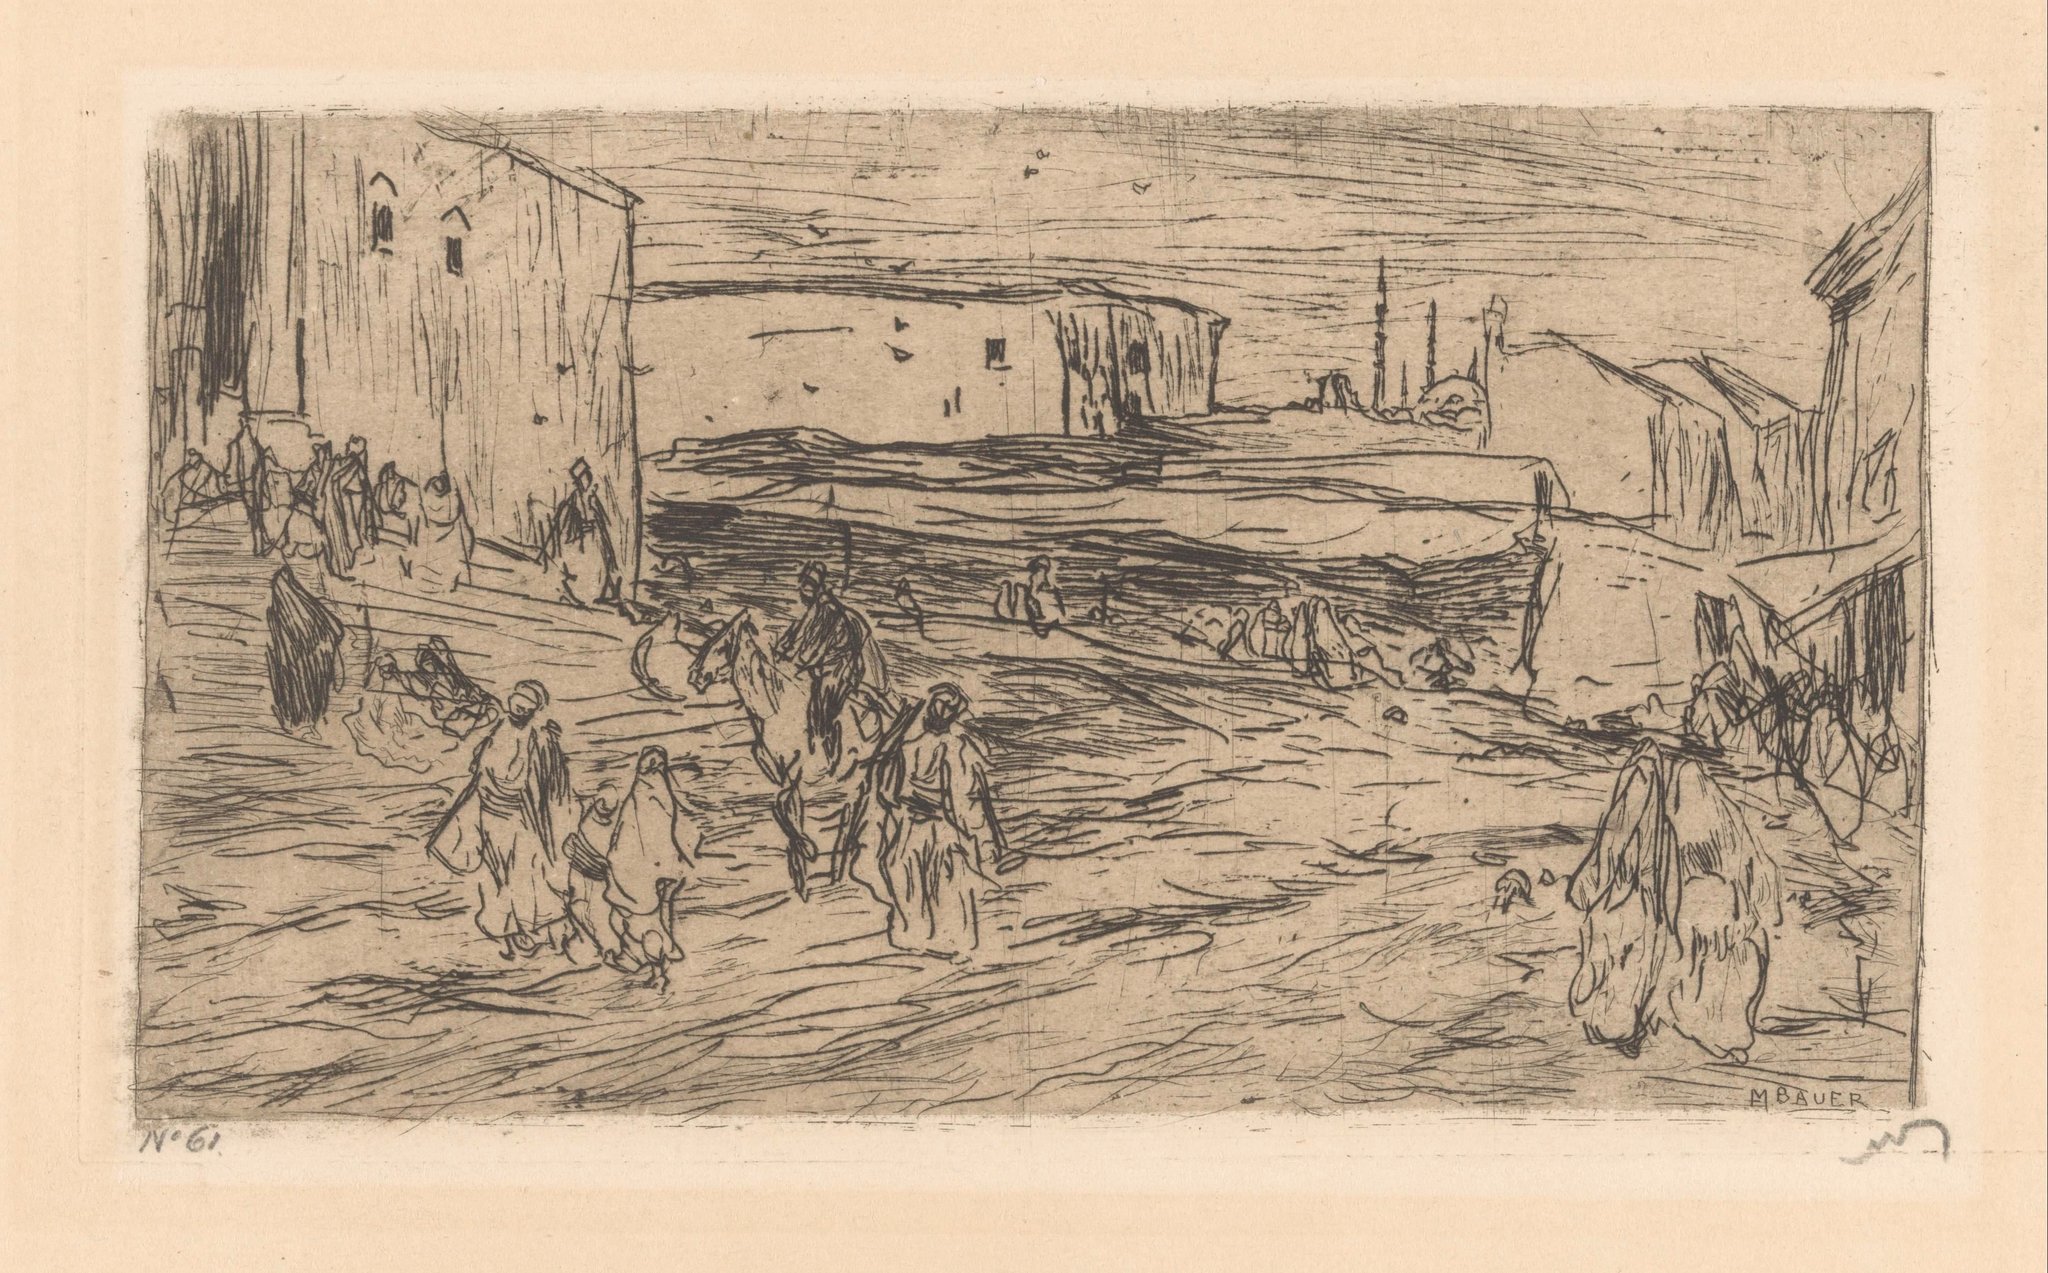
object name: print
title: Buitenwijken van Constantinopel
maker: marius bauer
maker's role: draughtsman, print maker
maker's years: 1867-1932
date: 1889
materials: paper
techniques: etching, intaglio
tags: temple, shrine ~ islam, mohammedanism, outskirts of city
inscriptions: collector's mark: Lugt 2228, collector's mark: Lugt 2760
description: Mannen en vrouwen in oosterse kleding op een terrein dat is omgeven door bebouwing. Rechts op de achtergrond een moskee.